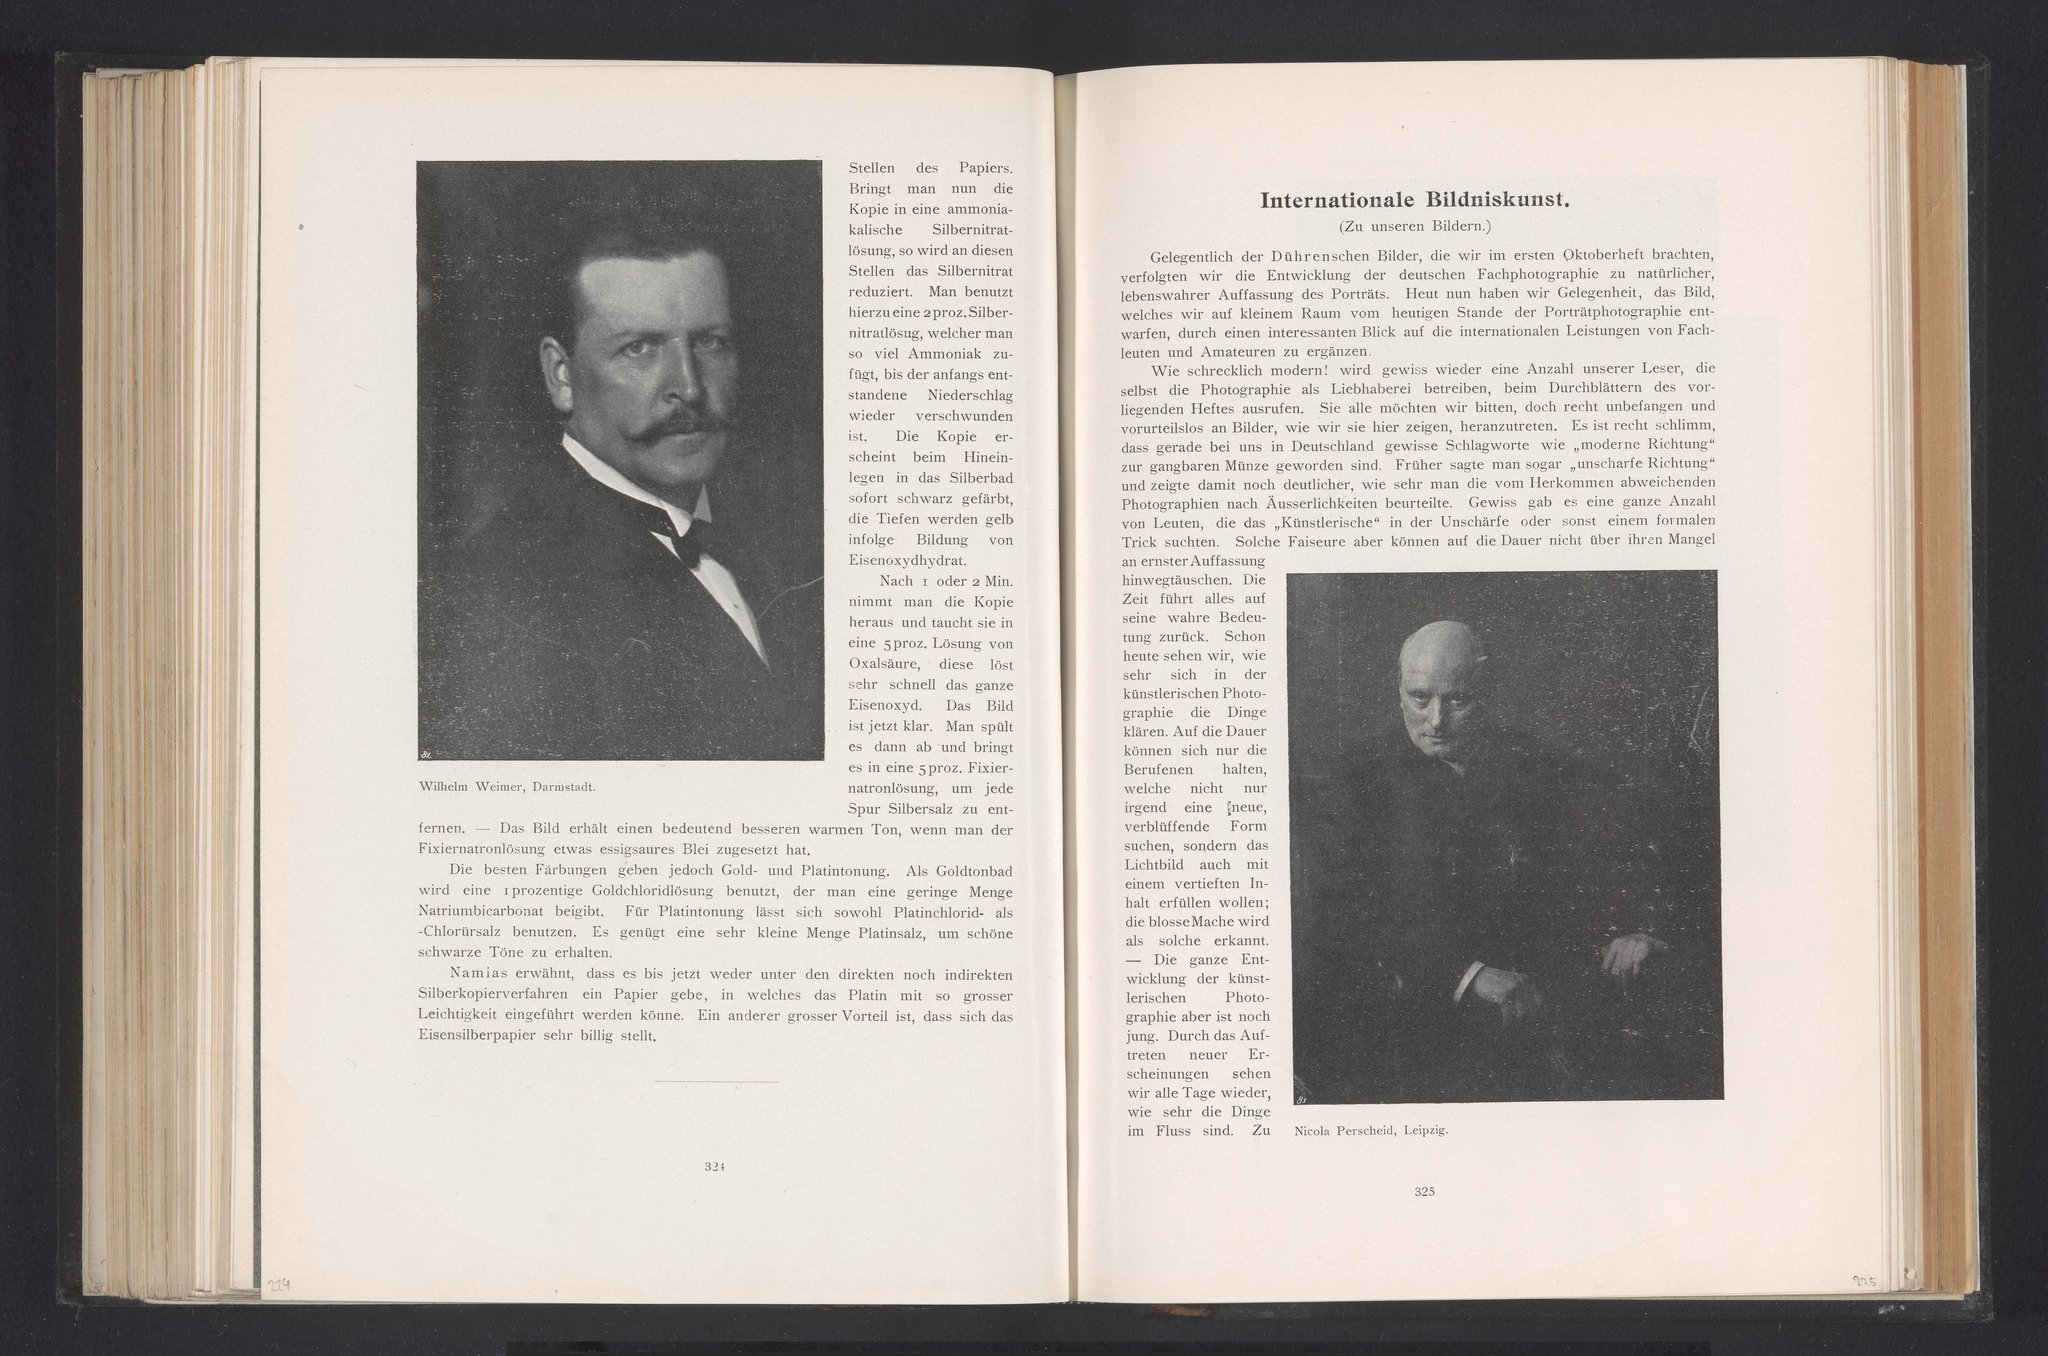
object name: page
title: Portret van een onbekende man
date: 1898-1903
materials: paper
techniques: autotype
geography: leipzig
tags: historical persons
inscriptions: monogram: ‘BX’